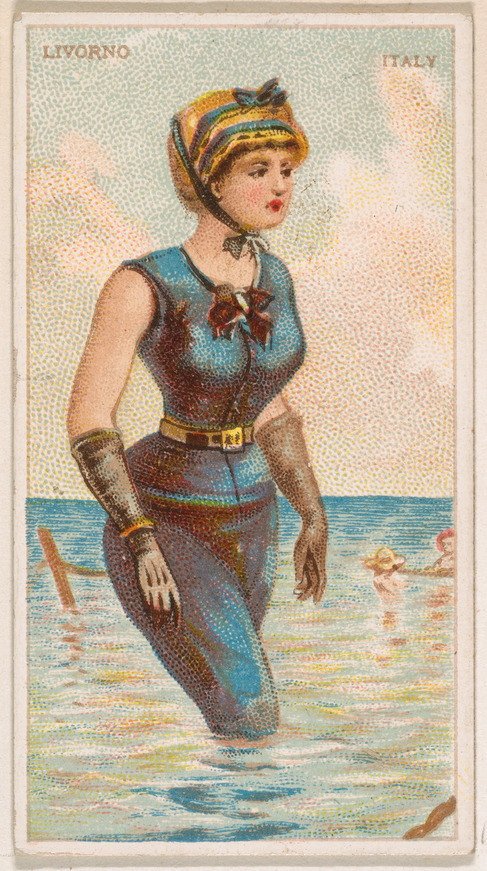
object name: print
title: Livorno, Italy, from the Surf Beauties series (N232), issued by Kinney Bros.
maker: kinney brothers tobacco company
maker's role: publisher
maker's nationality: american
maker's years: 1869-2011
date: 1889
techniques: color lithograph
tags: women,sports